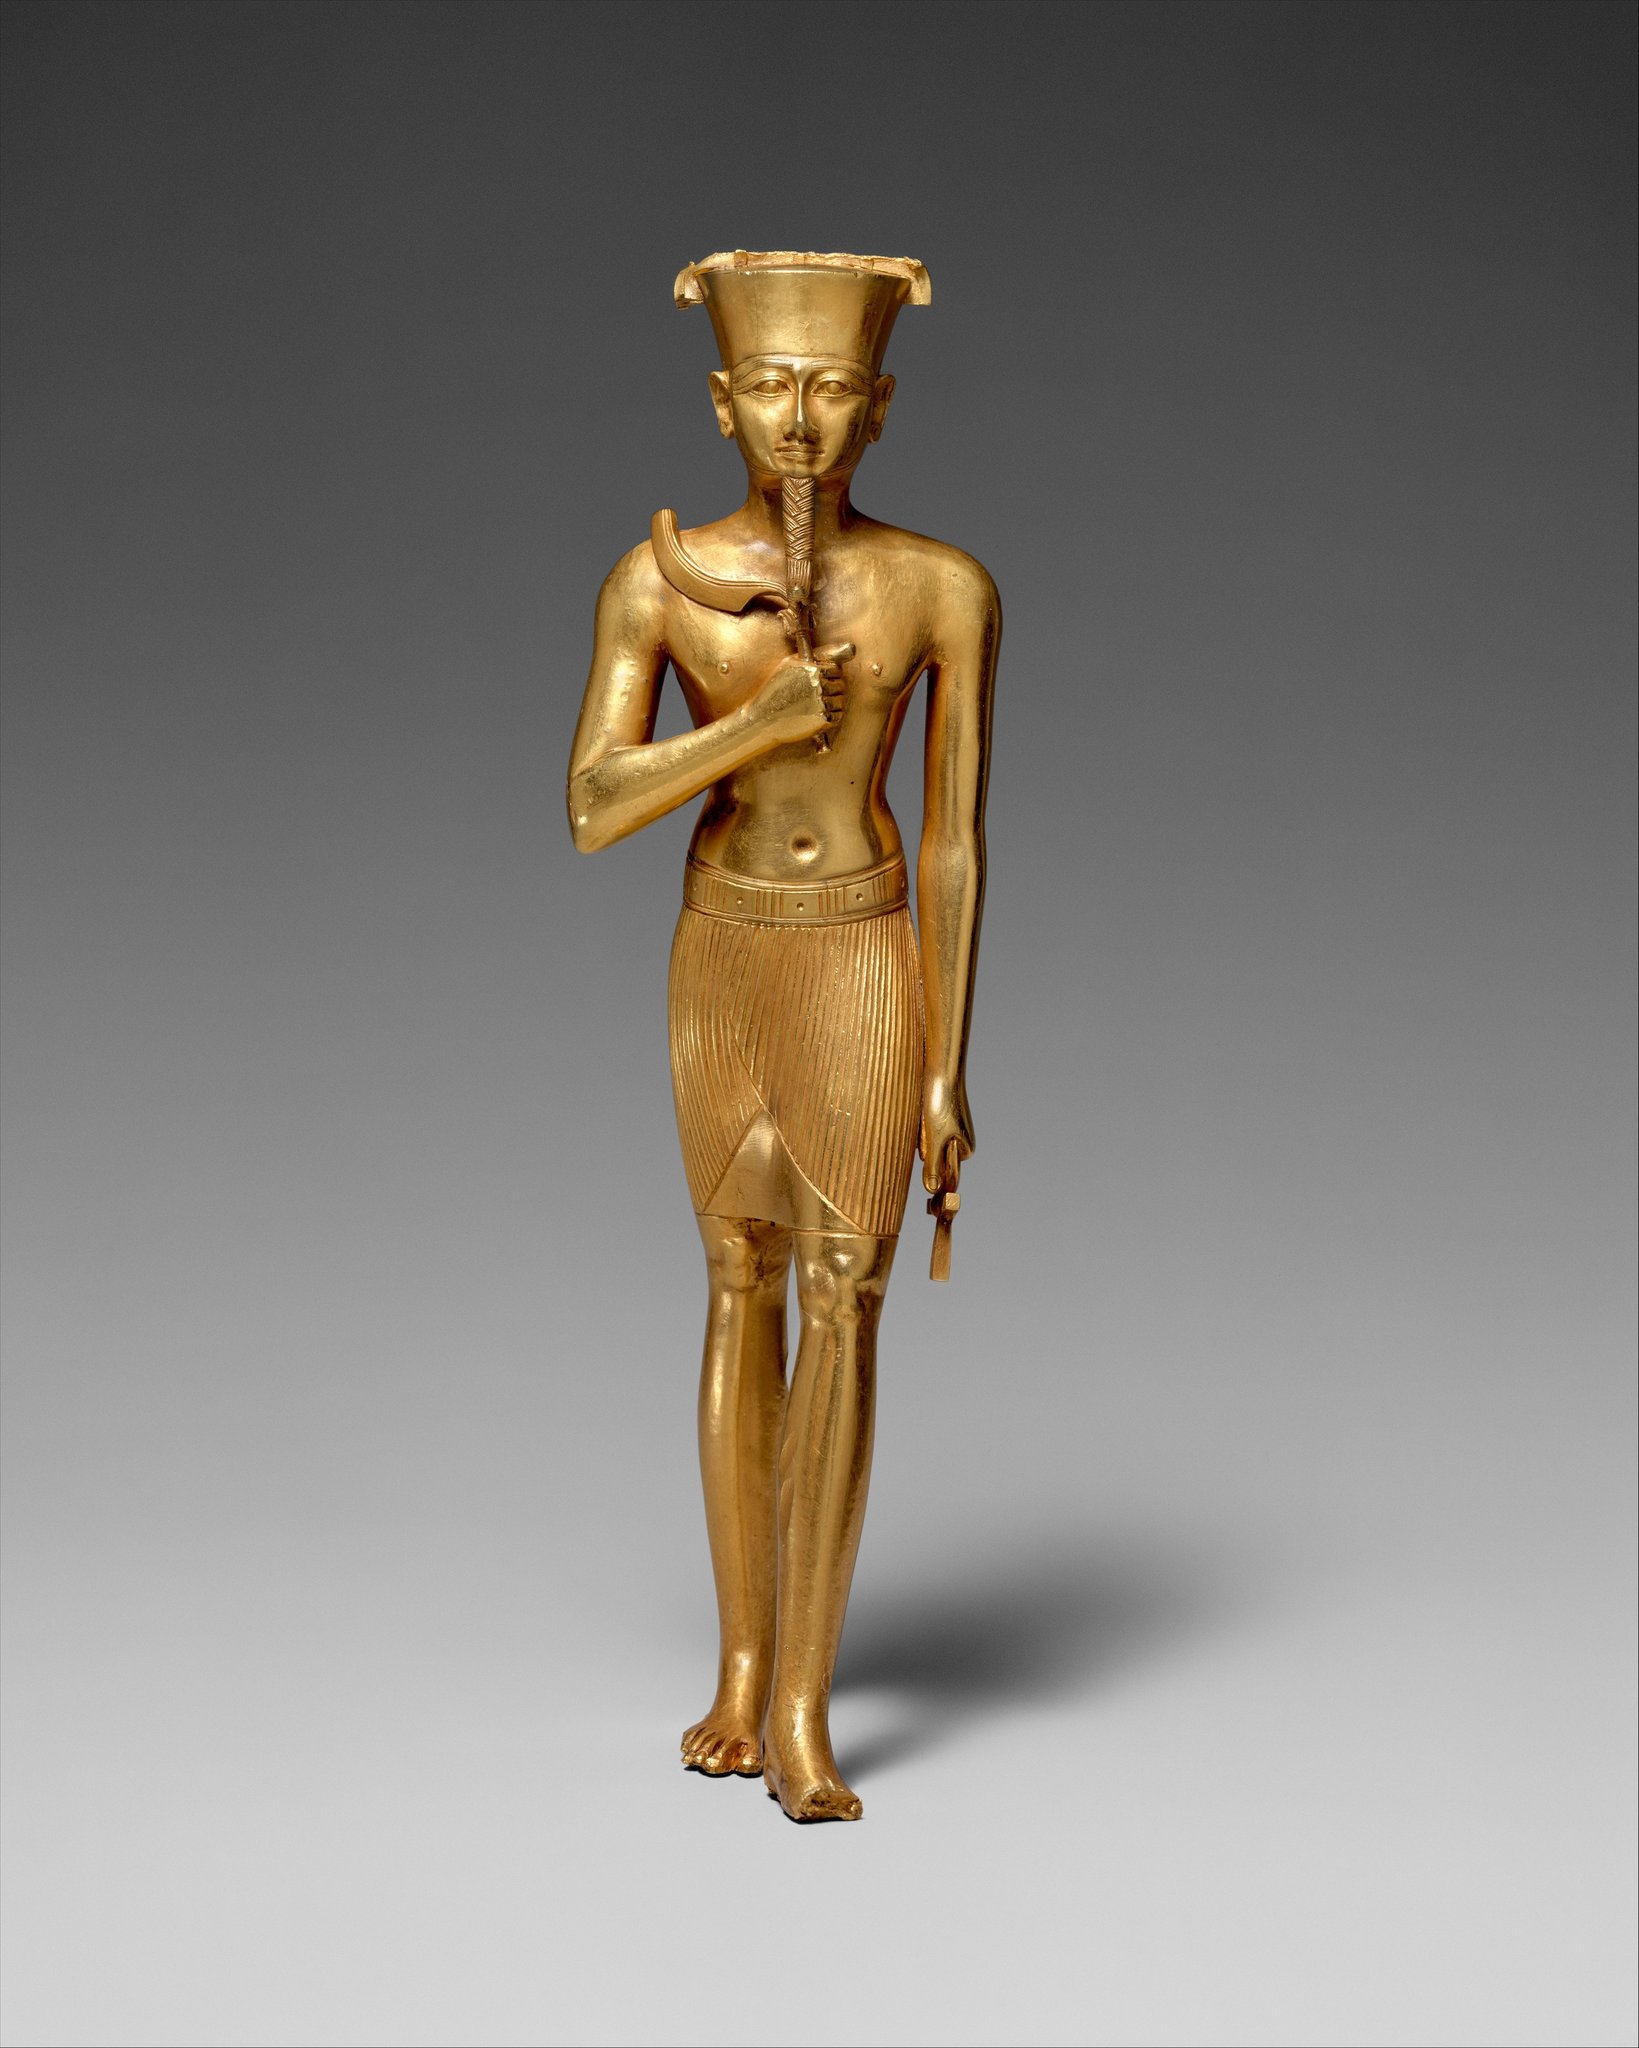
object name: statuette, amun, standing, god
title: Statuette of Amun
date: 945-712 BCE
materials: gold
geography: upper egypt, thebes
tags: men,amun